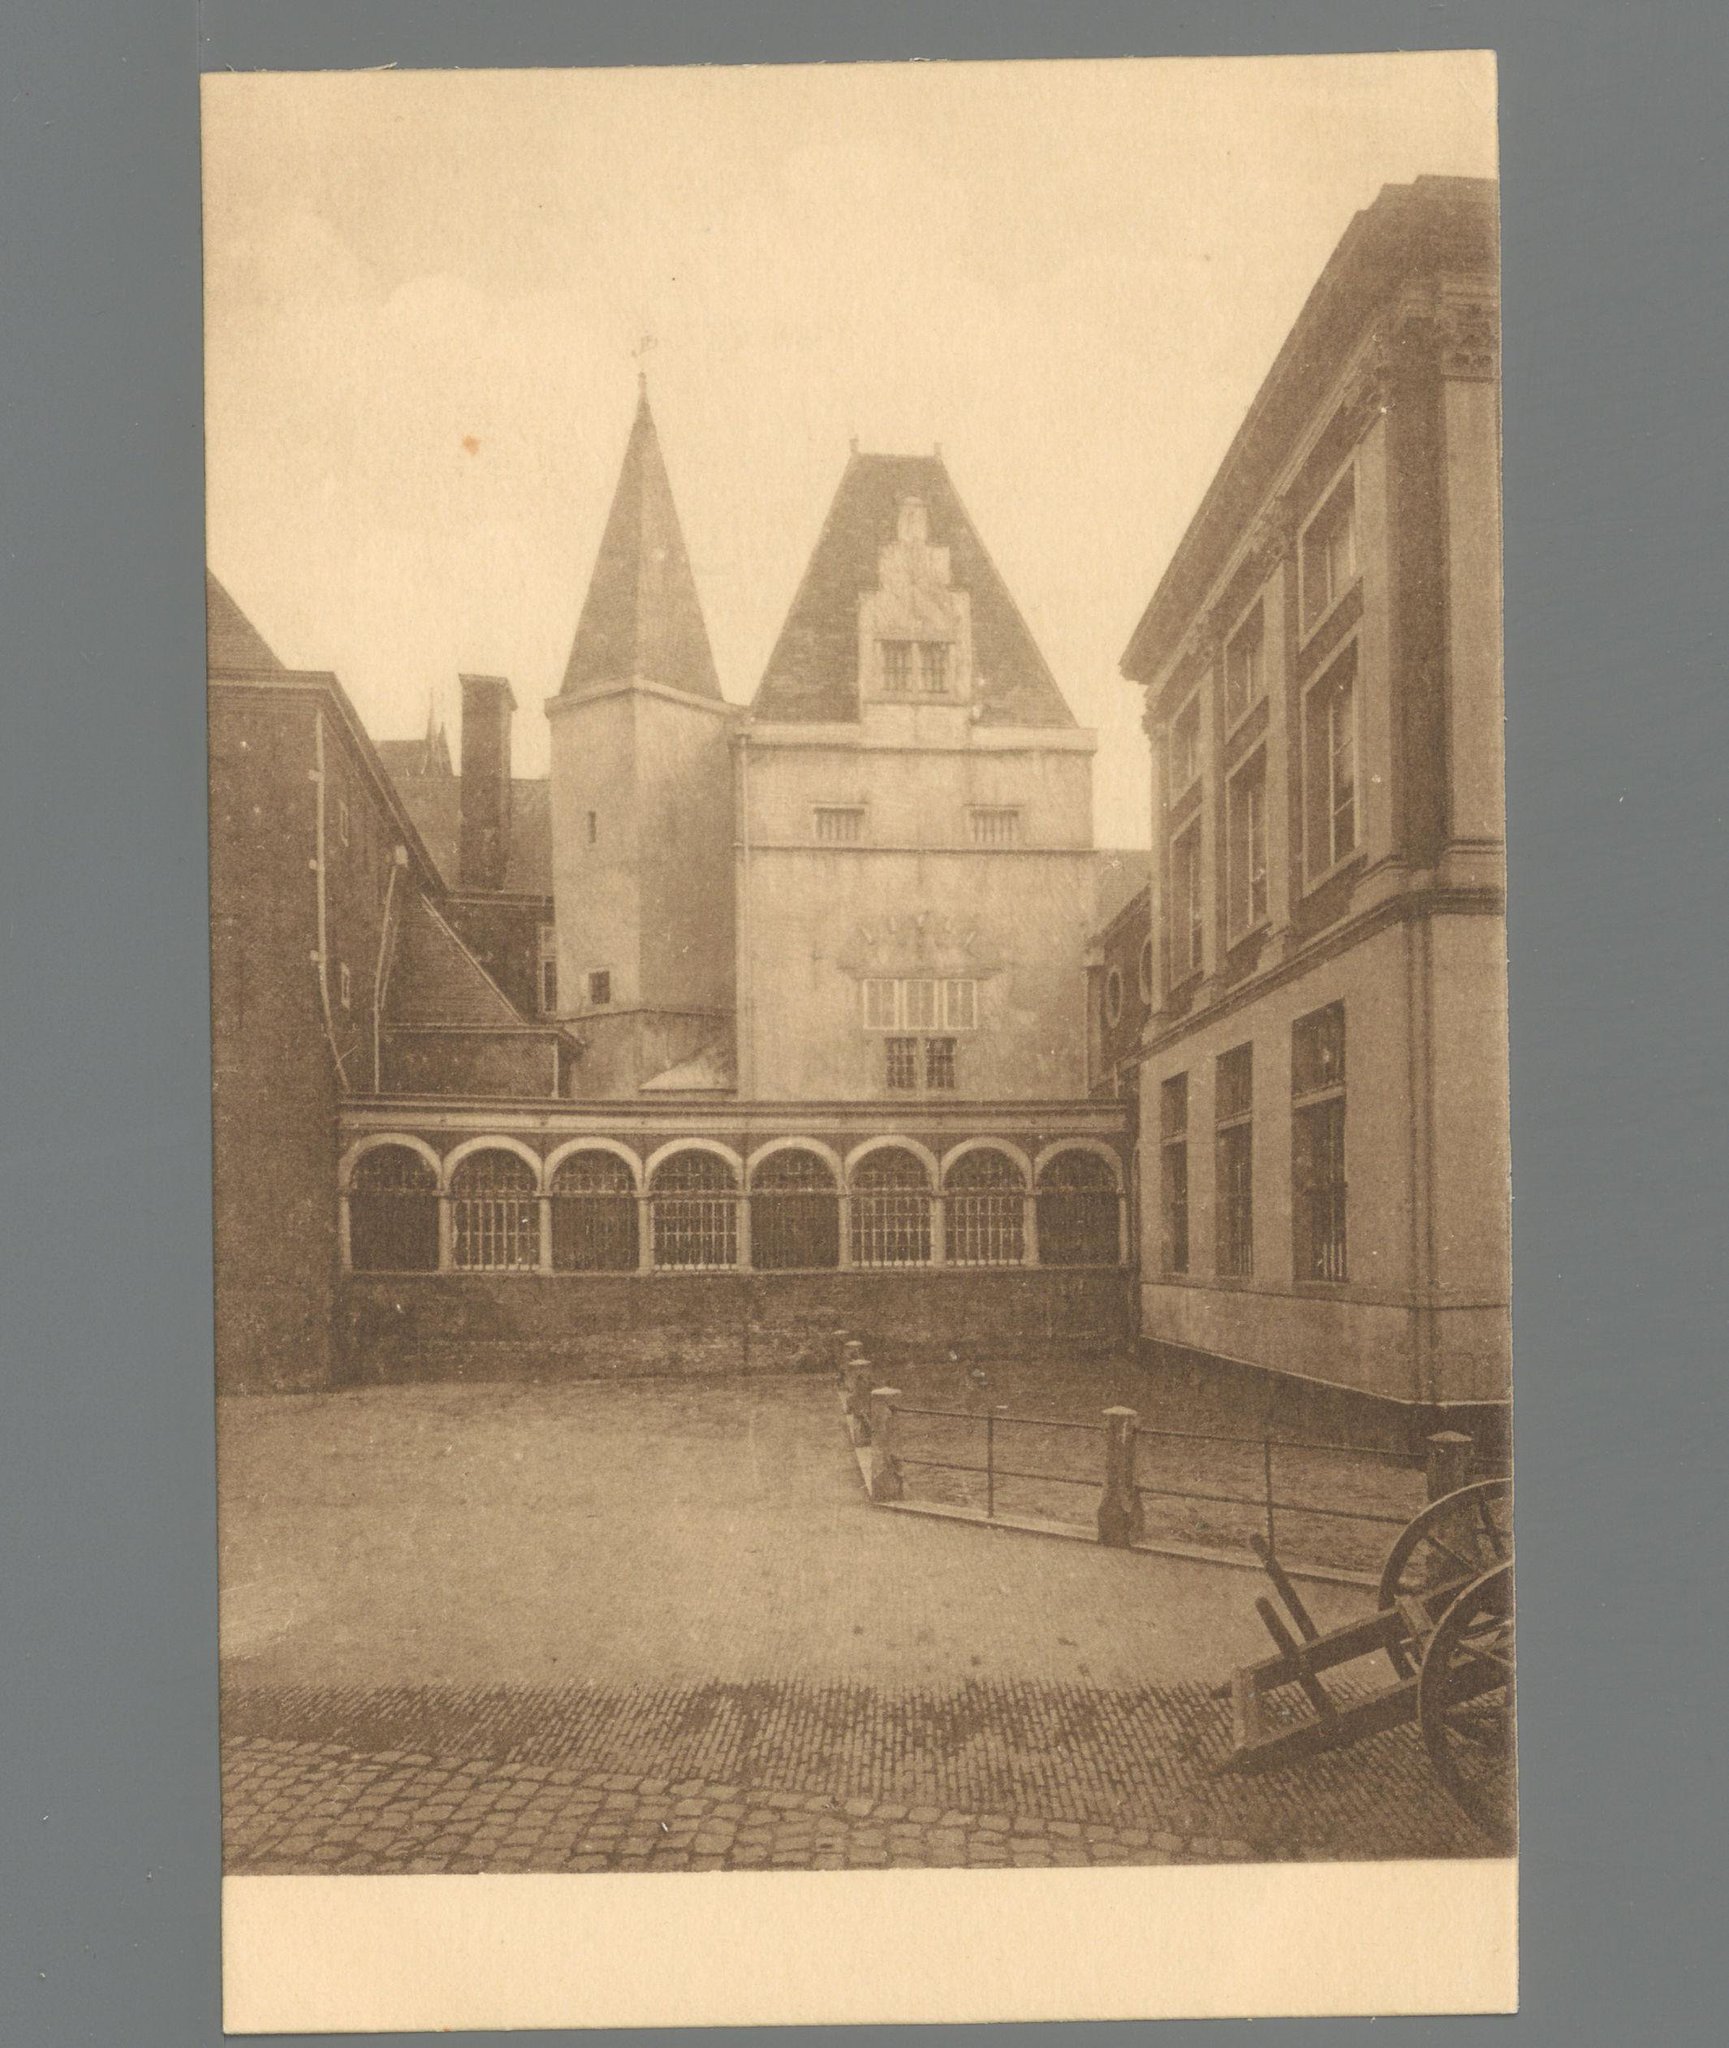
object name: photomechanical print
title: Leiden. Gravenstein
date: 1905-1930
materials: cardboard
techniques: photograph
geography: leiden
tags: prison, jail